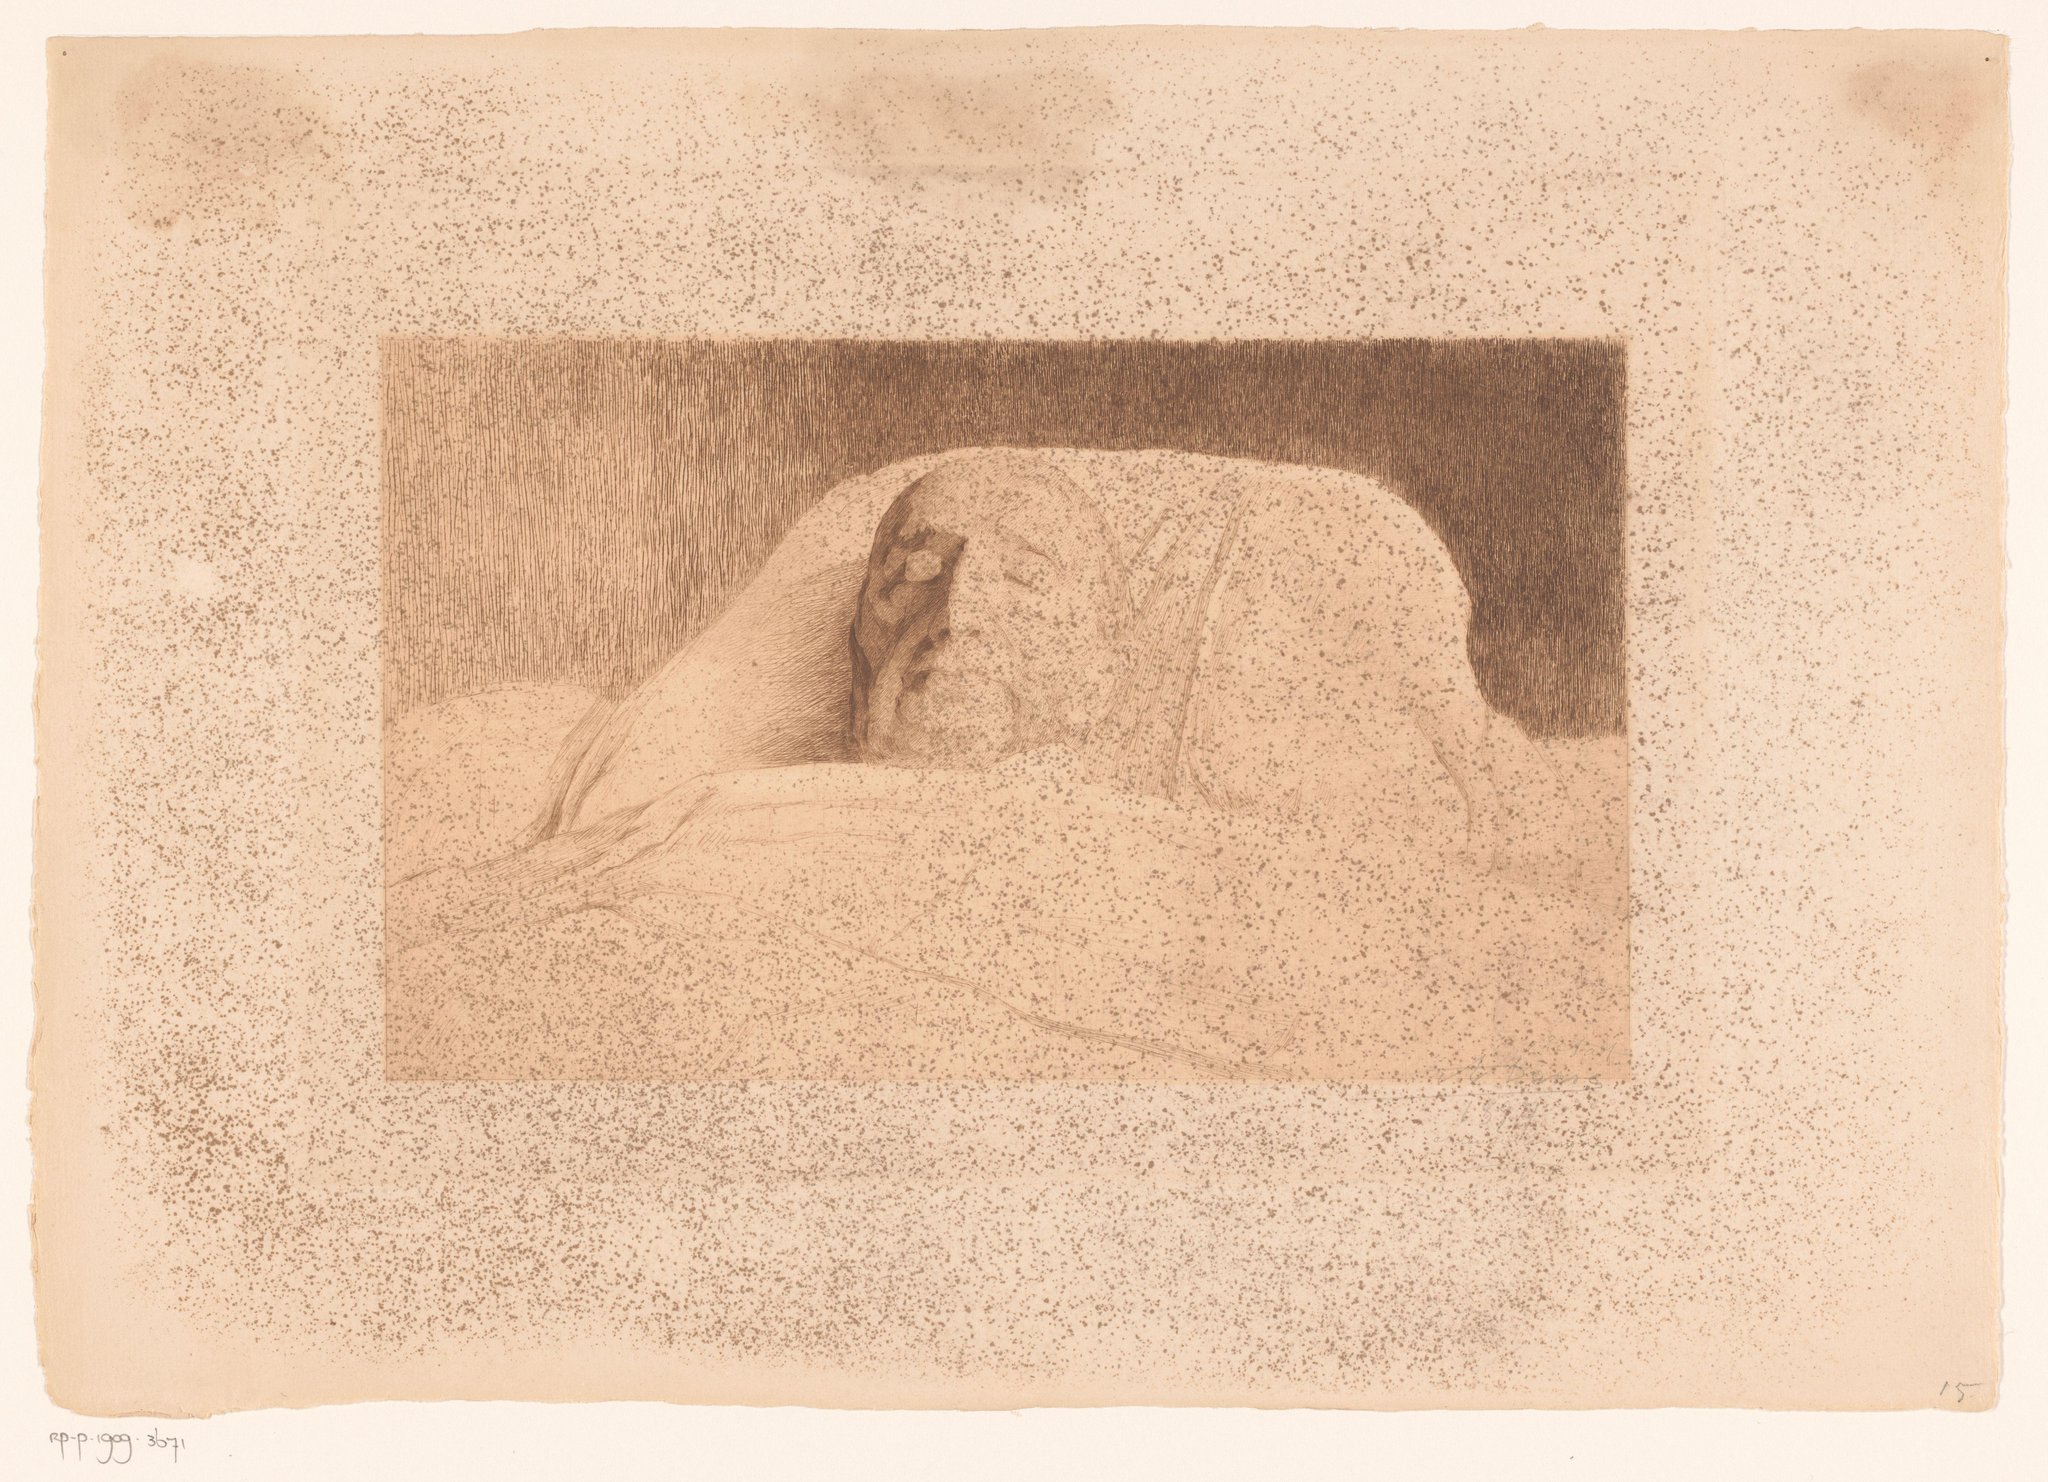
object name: print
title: Portret van een onbekende man op zijn sterfbed, mogelijk Van Volxem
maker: auguste danse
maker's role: print maker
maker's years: 1829-1929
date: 1897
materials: paper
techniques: etching, intaglio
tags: death in old age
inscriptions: collector's mark: Lugt 2228, annotation: ‘2me etat’